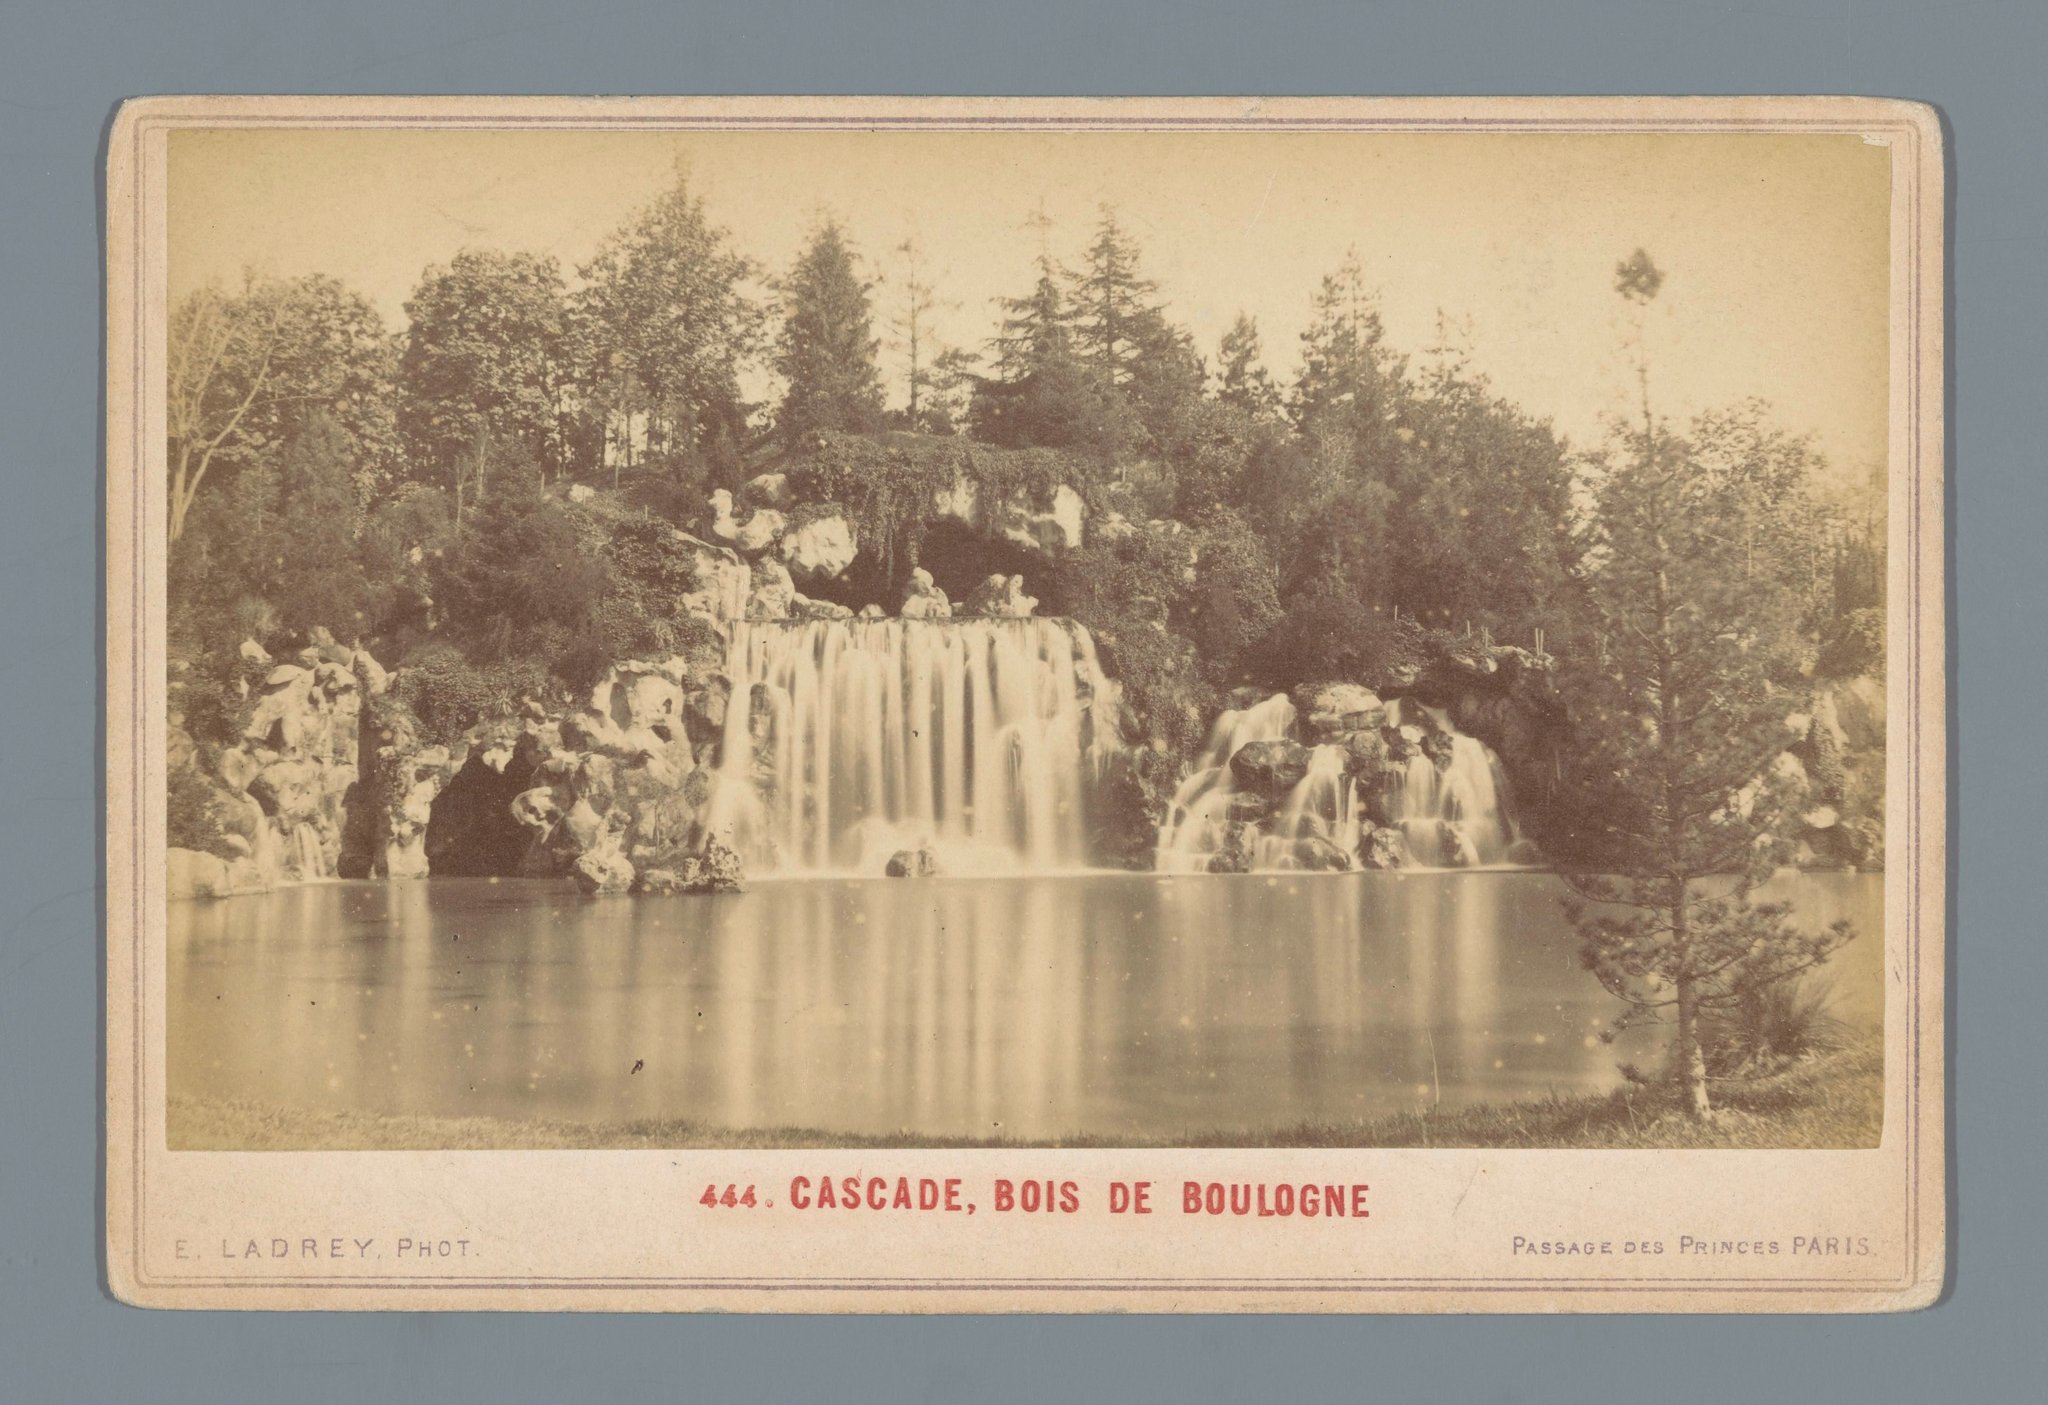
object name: cabinet photograph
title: Cascade, Bois de Boulogne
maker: ernest ladrey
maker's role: fotograaf, illustrator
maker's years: 1830-1889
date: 1860-1880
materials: cardboard, photographic support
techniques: albumen print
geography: paris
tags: waterfall, public gardens, park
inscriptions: retailer's mark: ‘Maison Martinet/ 12, boulevard des capucines 12/ Grand-Hotel/ Paris.’, number: ‘444.’, : ‘Passage des Princes PARIS.’